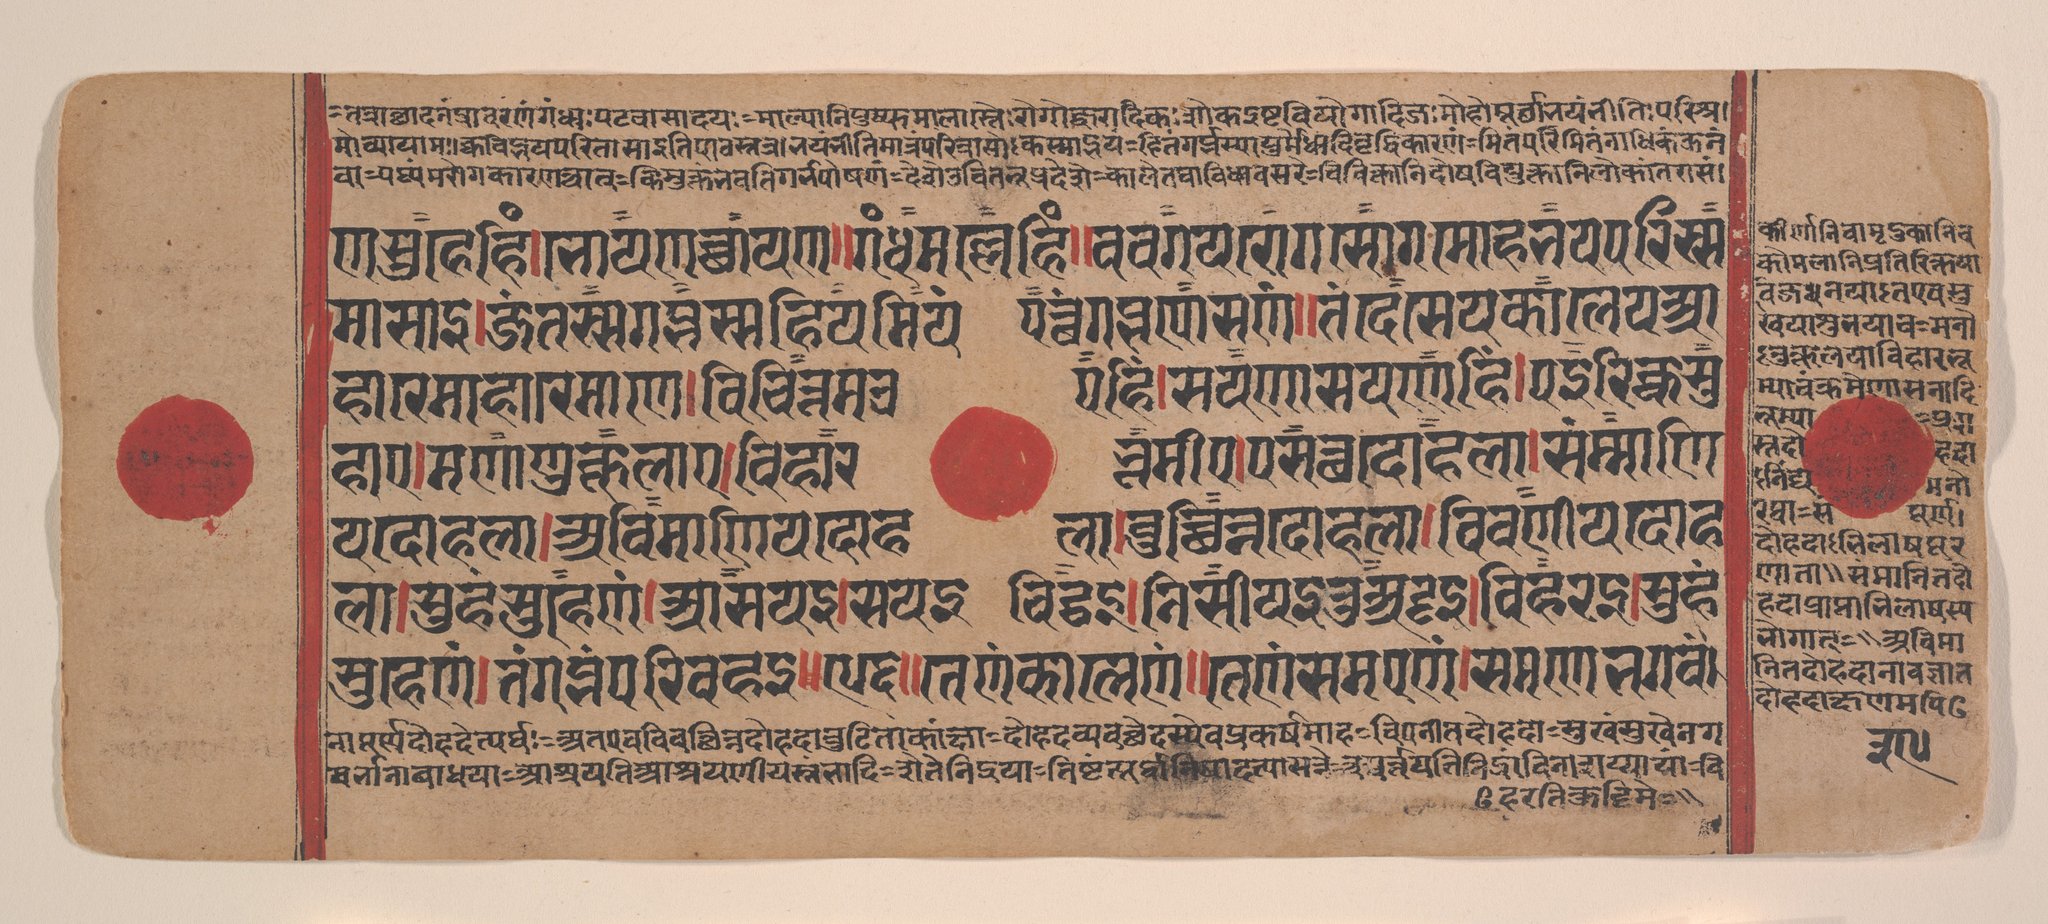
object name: folio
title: Page from a Dispersed Kalpa Sutra (Jain Book of Rituals)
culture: indian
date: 1401-1500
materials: gold, ink, paper, watercolor